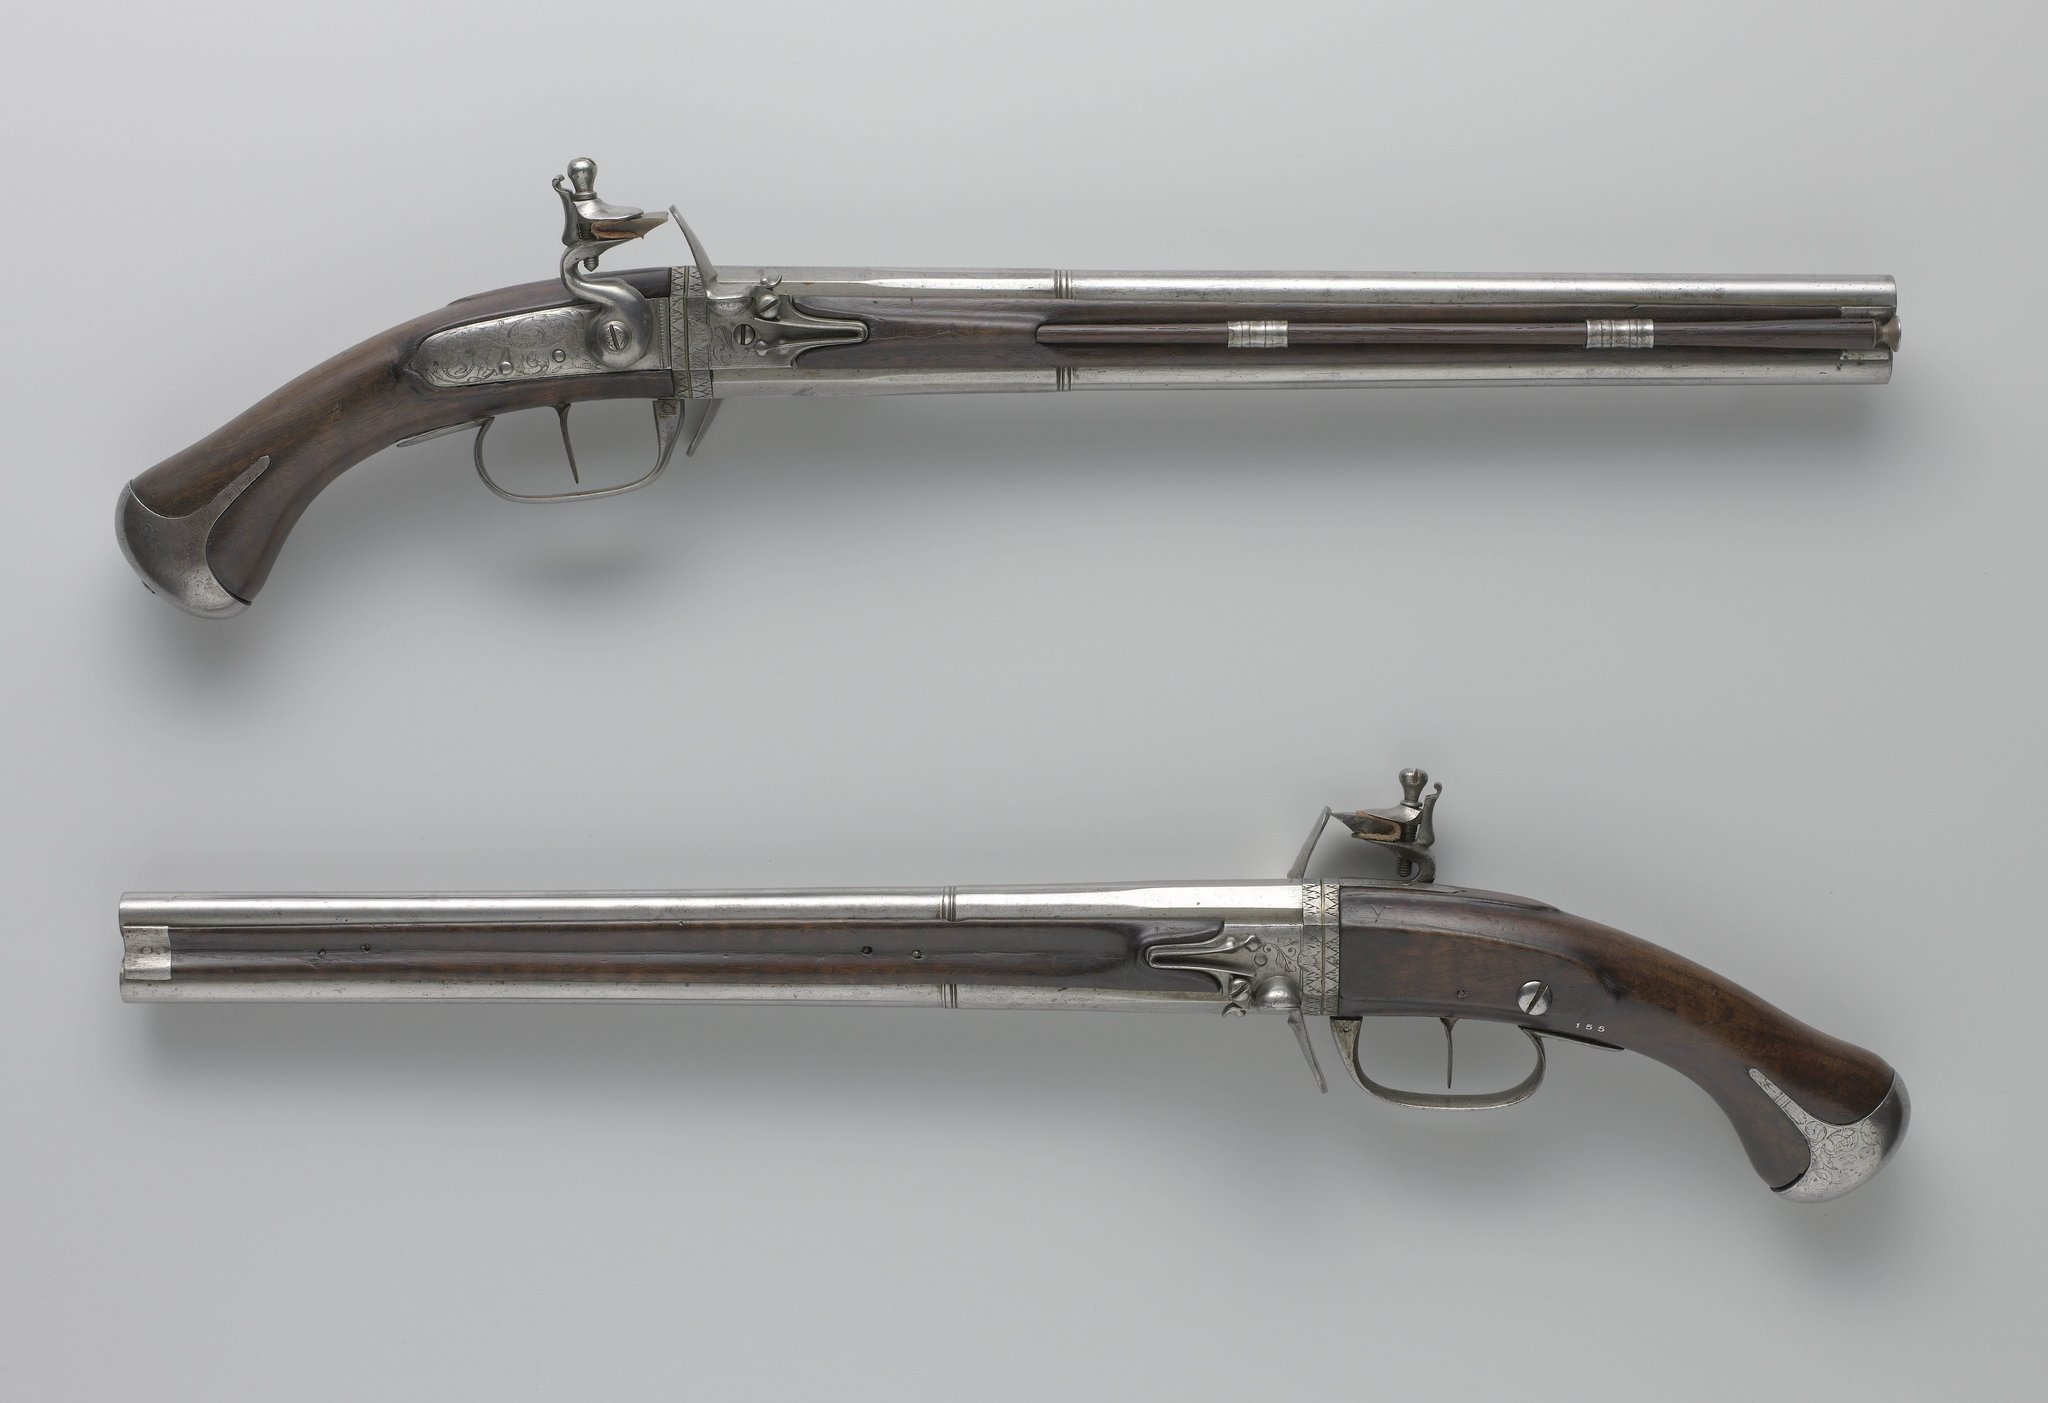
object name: draailooppistool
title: Dubbelloops vuursteendraailooppistool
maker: egbert tenckinck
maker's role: geweermaker, pistoolmaker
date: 1660-1665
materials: iron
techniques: engraving, striking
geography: utrecht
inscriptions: inscription: ‘AMSTERDAM’, signature: ‘EGBERT TENCKINCK’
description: Deel van een koppel. Het slot is versierd met ranken met bladeren en halfmens-halfdierfiguren die een gekrulde banderol dragen met een signatuur erop en een tulp. De twee lopen zijn boven elkaar gemonteerd en voorzien van een inscriptie. De kolf heeft twee groeven, waarvan een plaats biedt aan de laadstok. Het beslag bestaat uit onder meer twee laadstokkokers, een trekkerbeugel, een kolfkap gegraveerd met ranken met bladeren en draken en een laadstok met ijzeren kap.